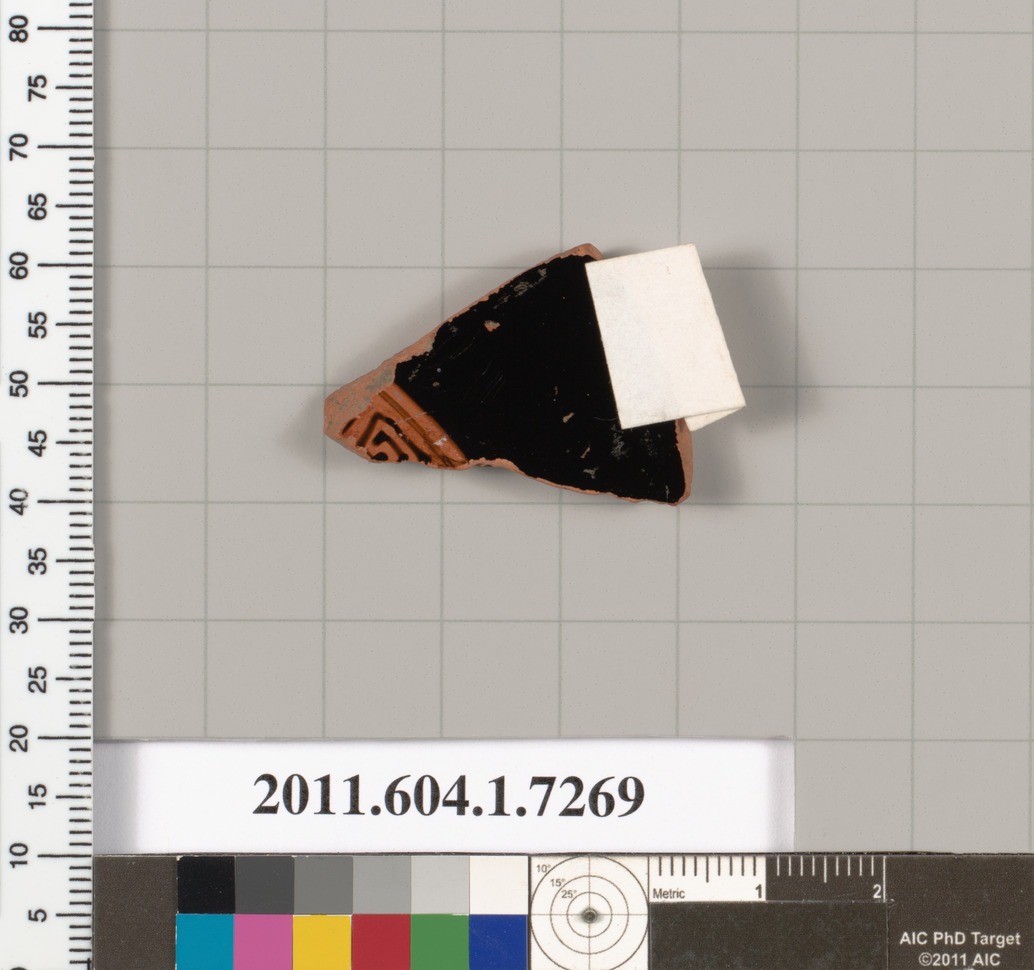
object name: kylix fragment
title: Terracotta fragment of a kylix (drinking cup)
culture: greek, attic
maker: makron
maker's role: artist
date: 500-480 BCE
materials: terracotta